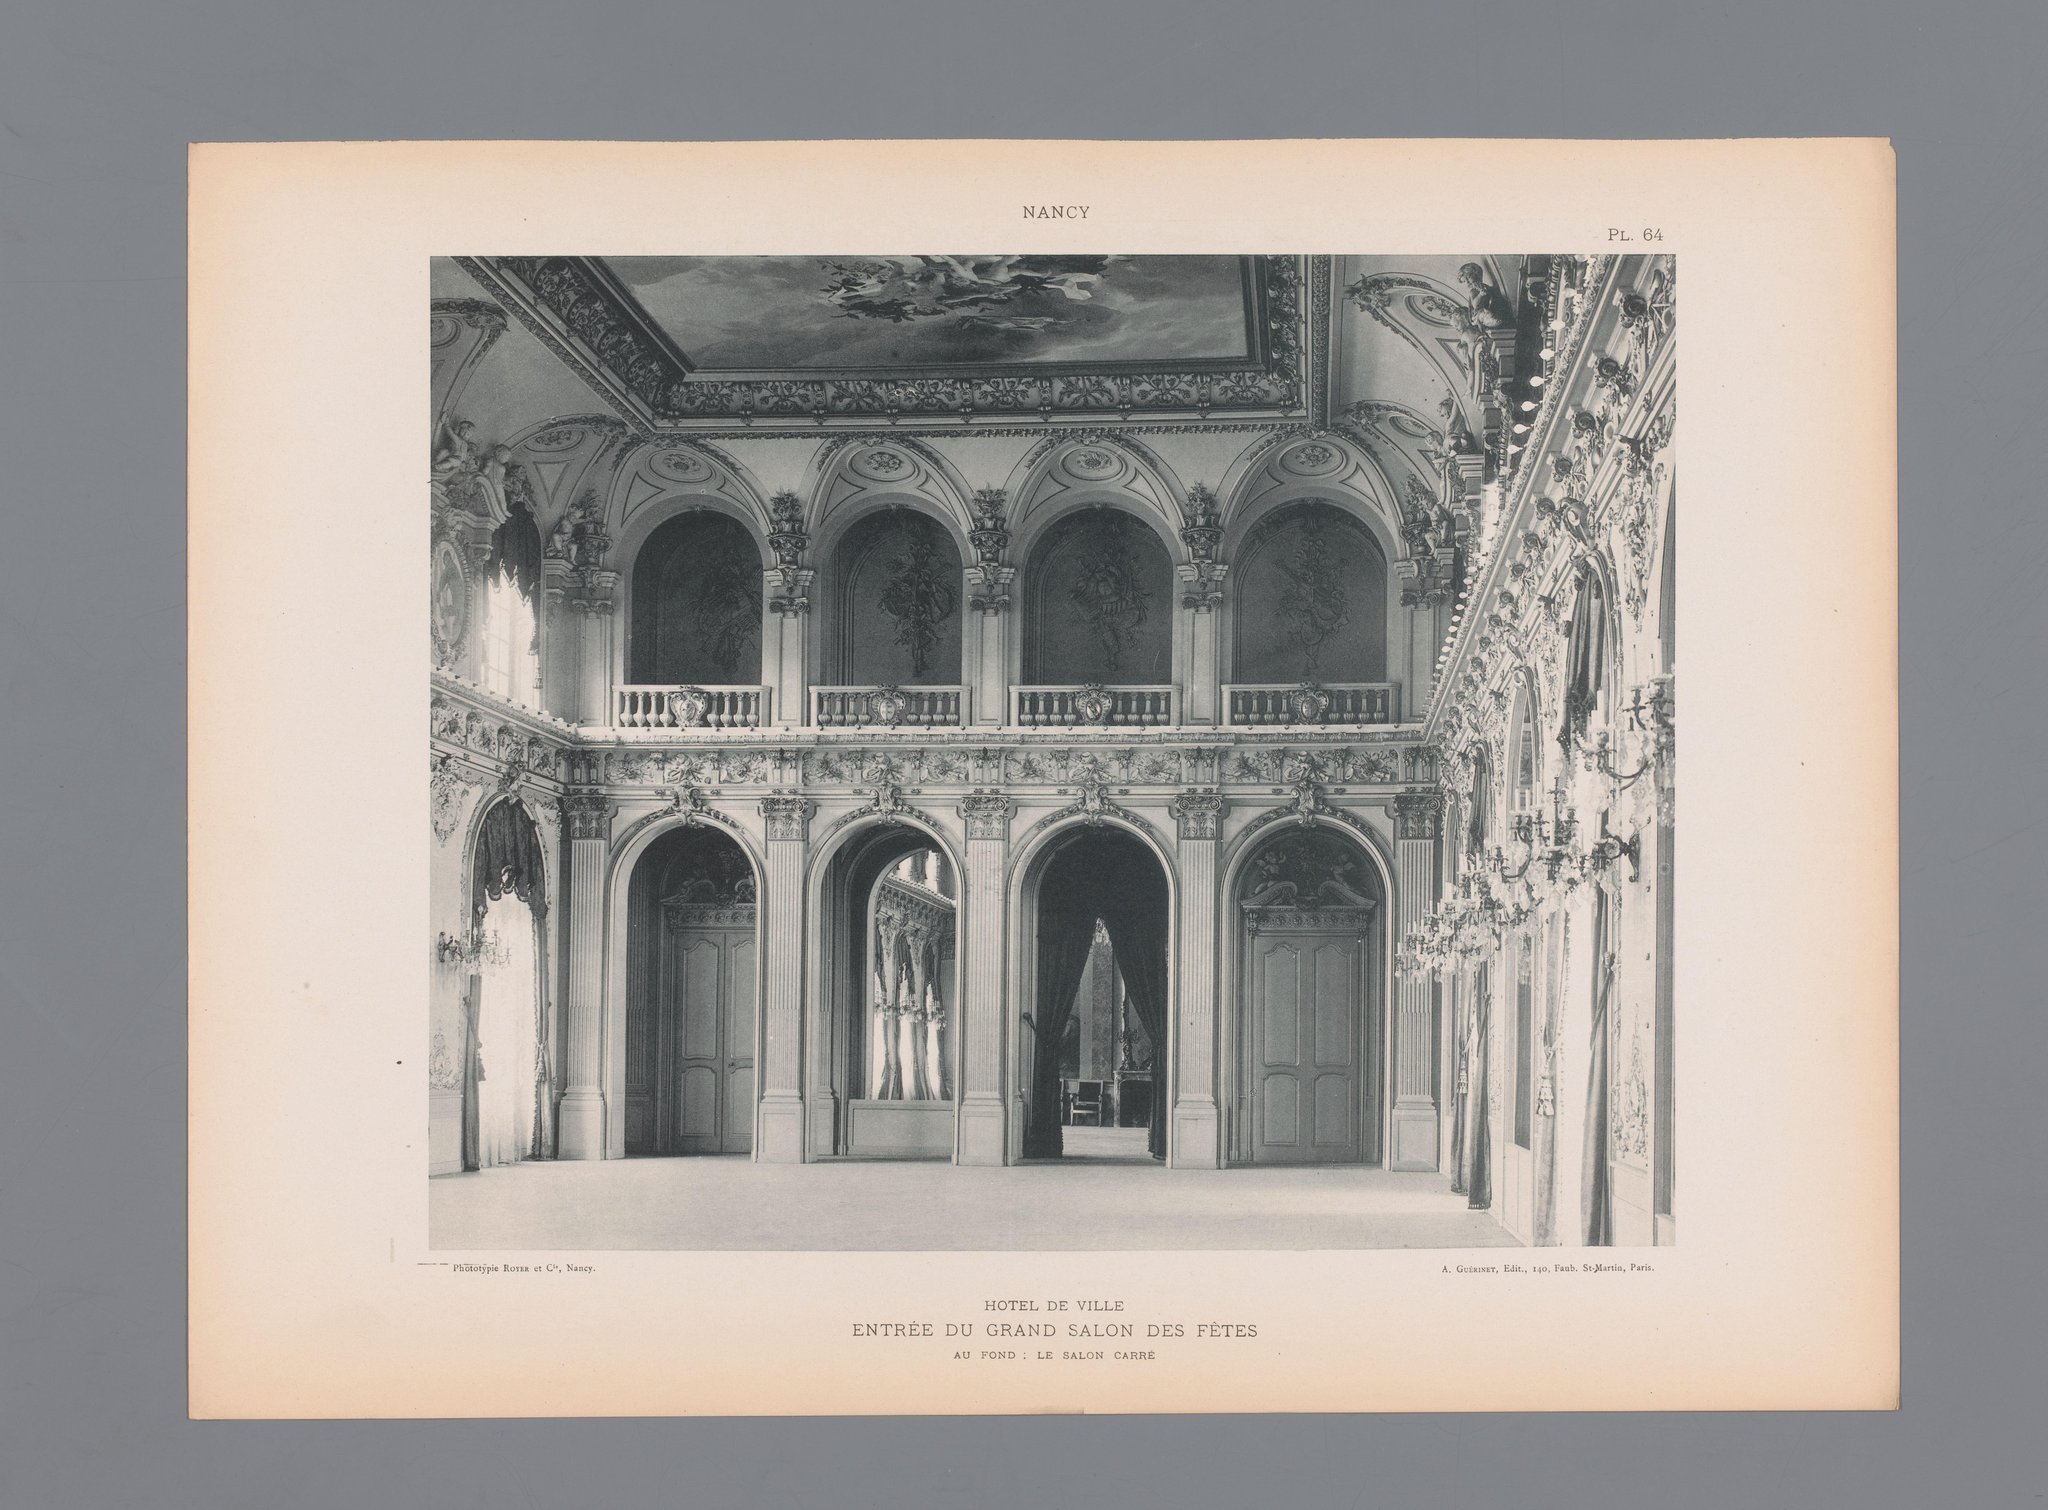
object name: photomechanical print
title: Feestzaal in het stadhuis te Nancy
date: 1891-1896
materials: paper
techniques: photograph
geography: nancy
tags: townhall, interior ~ representation of a building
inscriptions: inscription: ‘Hotel de ville/ Entrée du grand salon des fêtes (...)’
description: Deze prent maakt deel uit van een omslag met 103 prenten op 101 bladen en een titelblad.